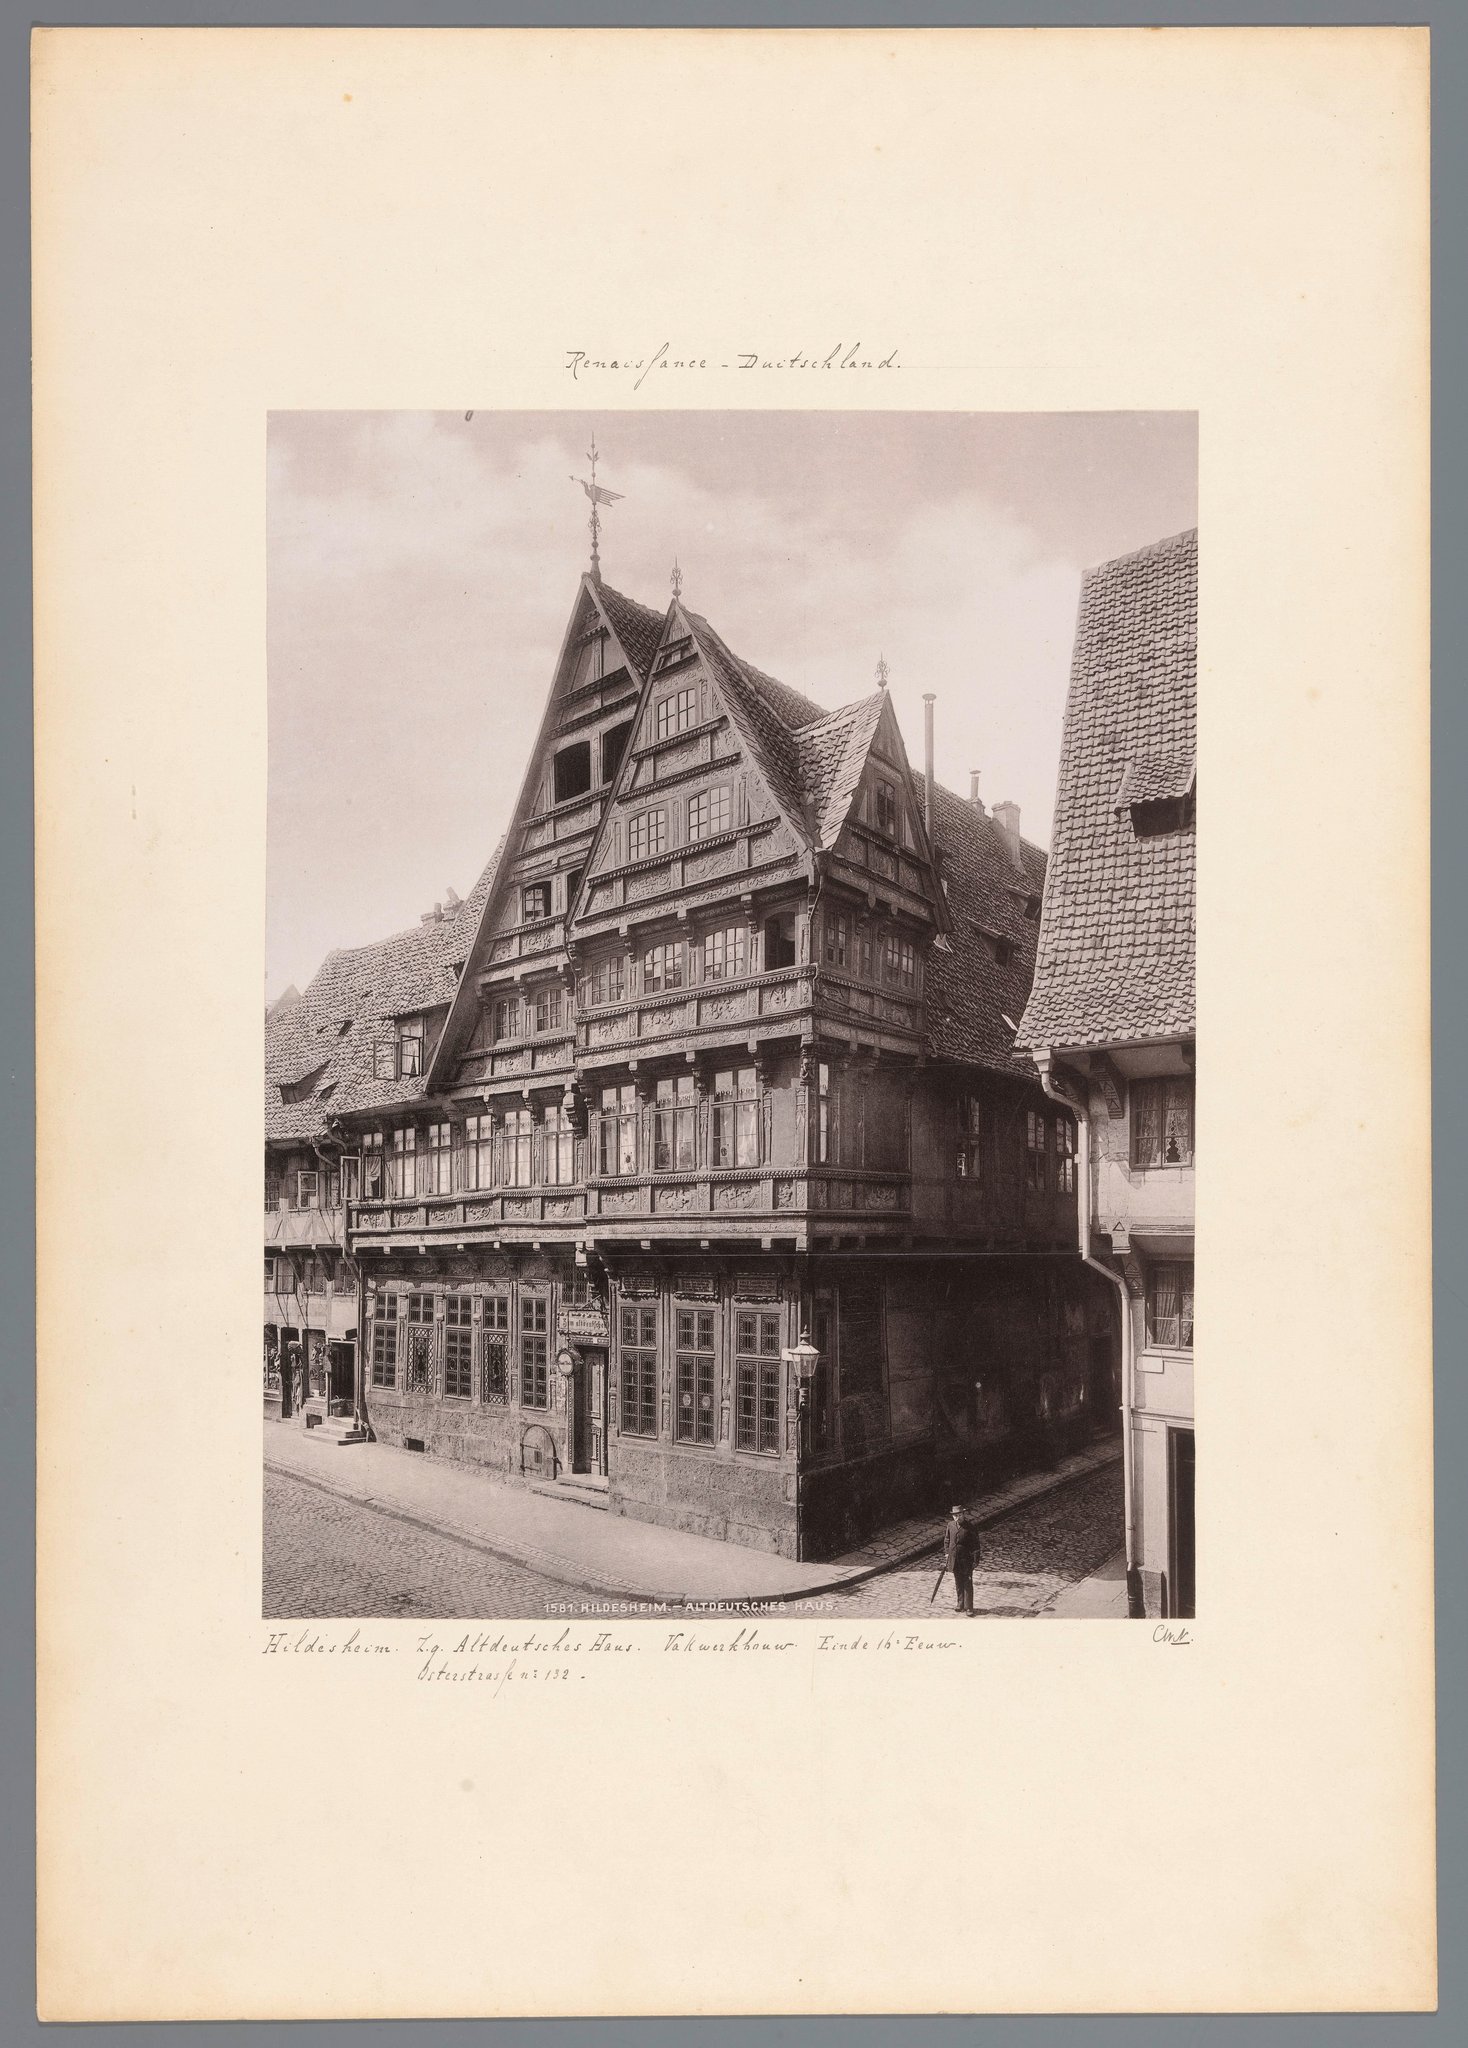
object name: photograph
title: HILDESHEIM. - ALTDEUTSCHES HAUS.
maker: Anonymous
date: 1875-1900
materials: cardboard, paper, ink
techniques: photograph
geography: hildesheim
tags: urban housing, street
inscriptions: collector's mark: ‘KUNSTNIJVERHEIDSCHOOL QUELLINUS AMSTERDAM FRANS HALSSTRAAT 14.’, inscription: ‘Renaissance - Duitschland.’, number: ‘1581.’, collector's mark: ‘INSTITUUT VOOR KUNST-NIJVERHEIDSONDERWIJS GABRIËL METSUSTRAAT No. 16 AMSTERDAM’, inscription: ‘CWN.’